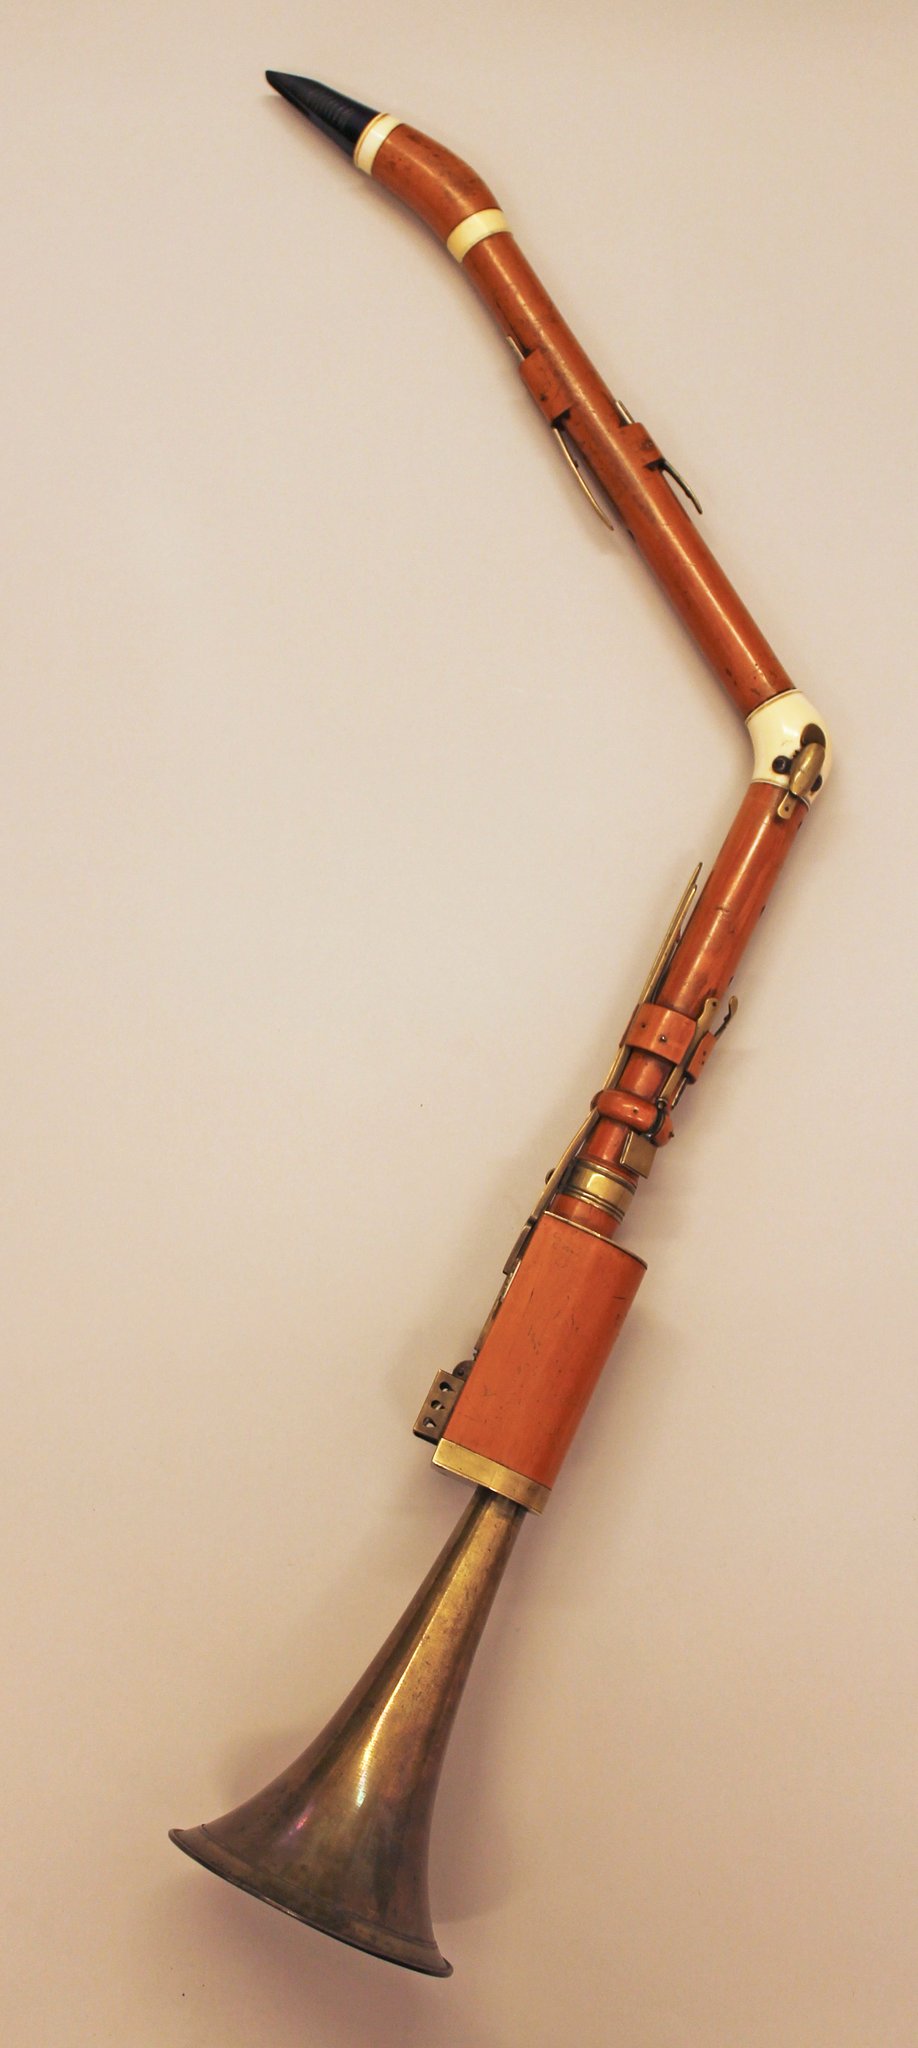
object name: basset horn in f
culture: german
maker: johann gottlieb freyer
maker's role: maker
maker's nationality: german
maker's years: 1764-1808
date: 1800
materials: wood, brass, ivory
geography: germany